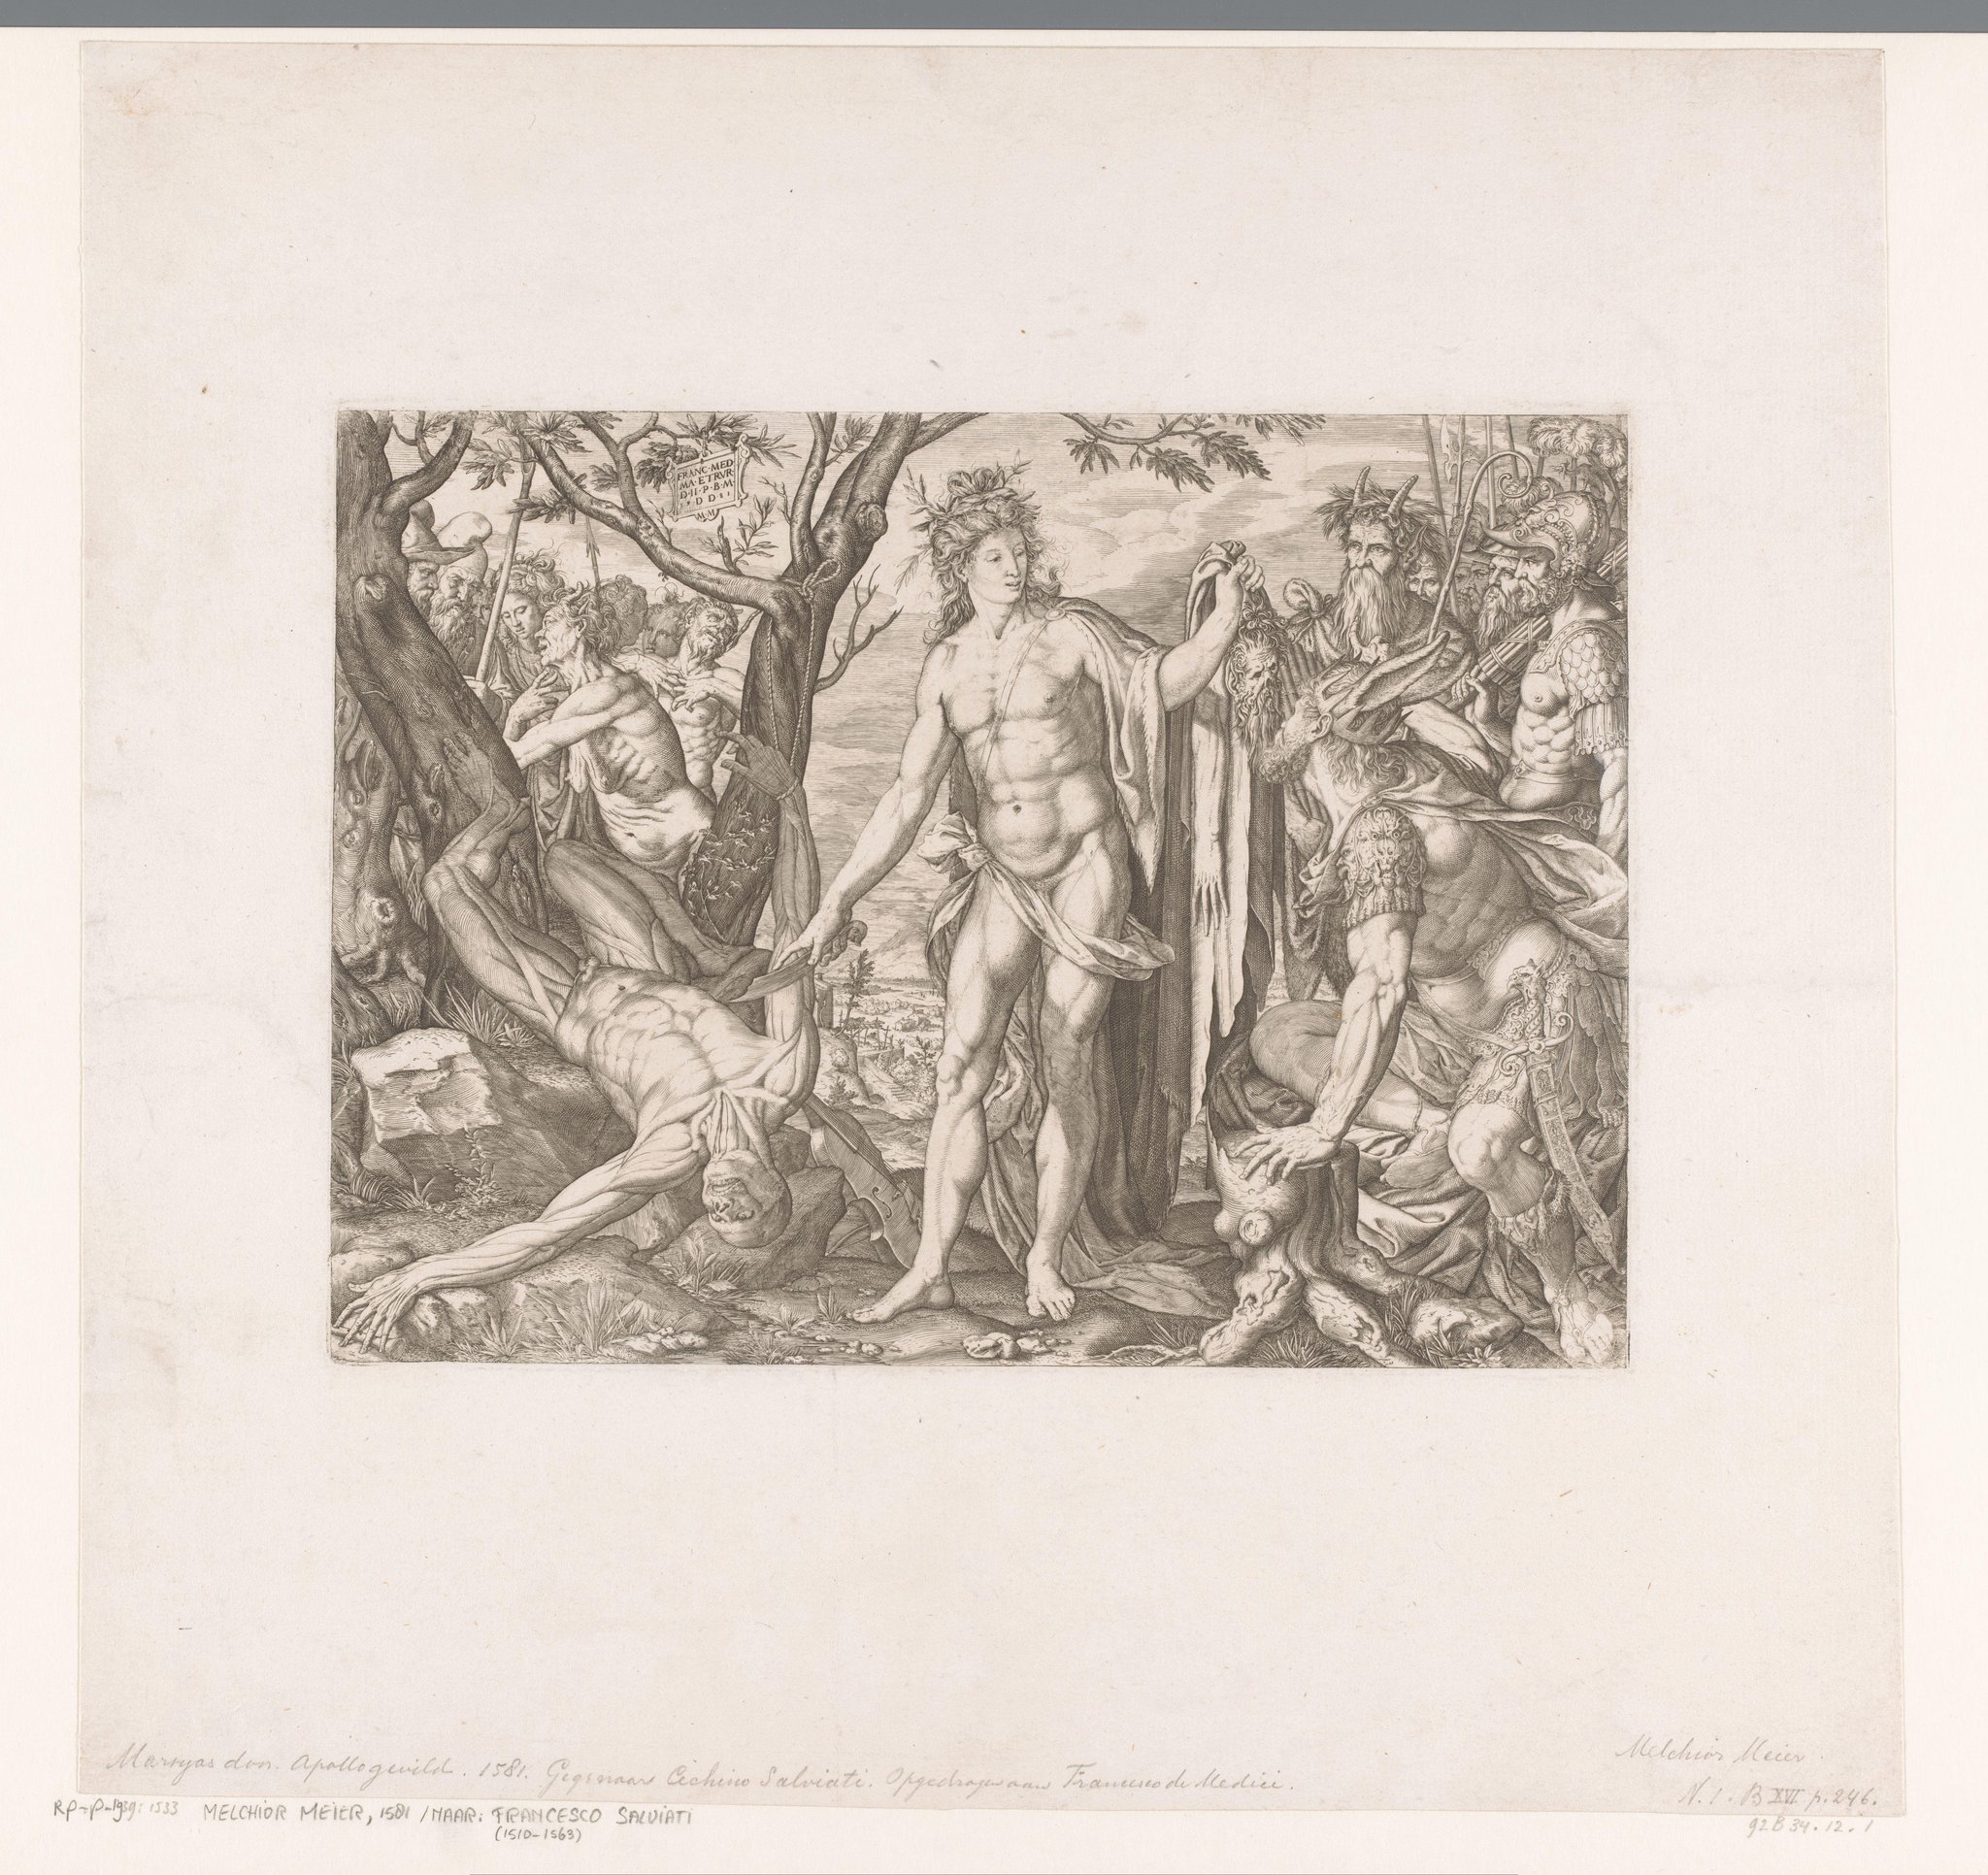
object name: print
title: Apollo en Marsyas en het oordeel van Midas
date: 1581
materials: paper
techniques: engraving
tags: punishment of marsyas: he is flayed by apollo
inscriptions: collector's mark: Lugt 2165, collector's mark: Lugt 2760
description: Apollo in het midden, met het mes in de hand waarmee zojuist Marsyas gevild is, wiens huid Apollo in zijn linker hand vast heeft. Marsyas zelf hangt zonder huid aan de boom. Rechts de knielende Midas met de ezelsoren, saters en soldaten in de achtergrond.